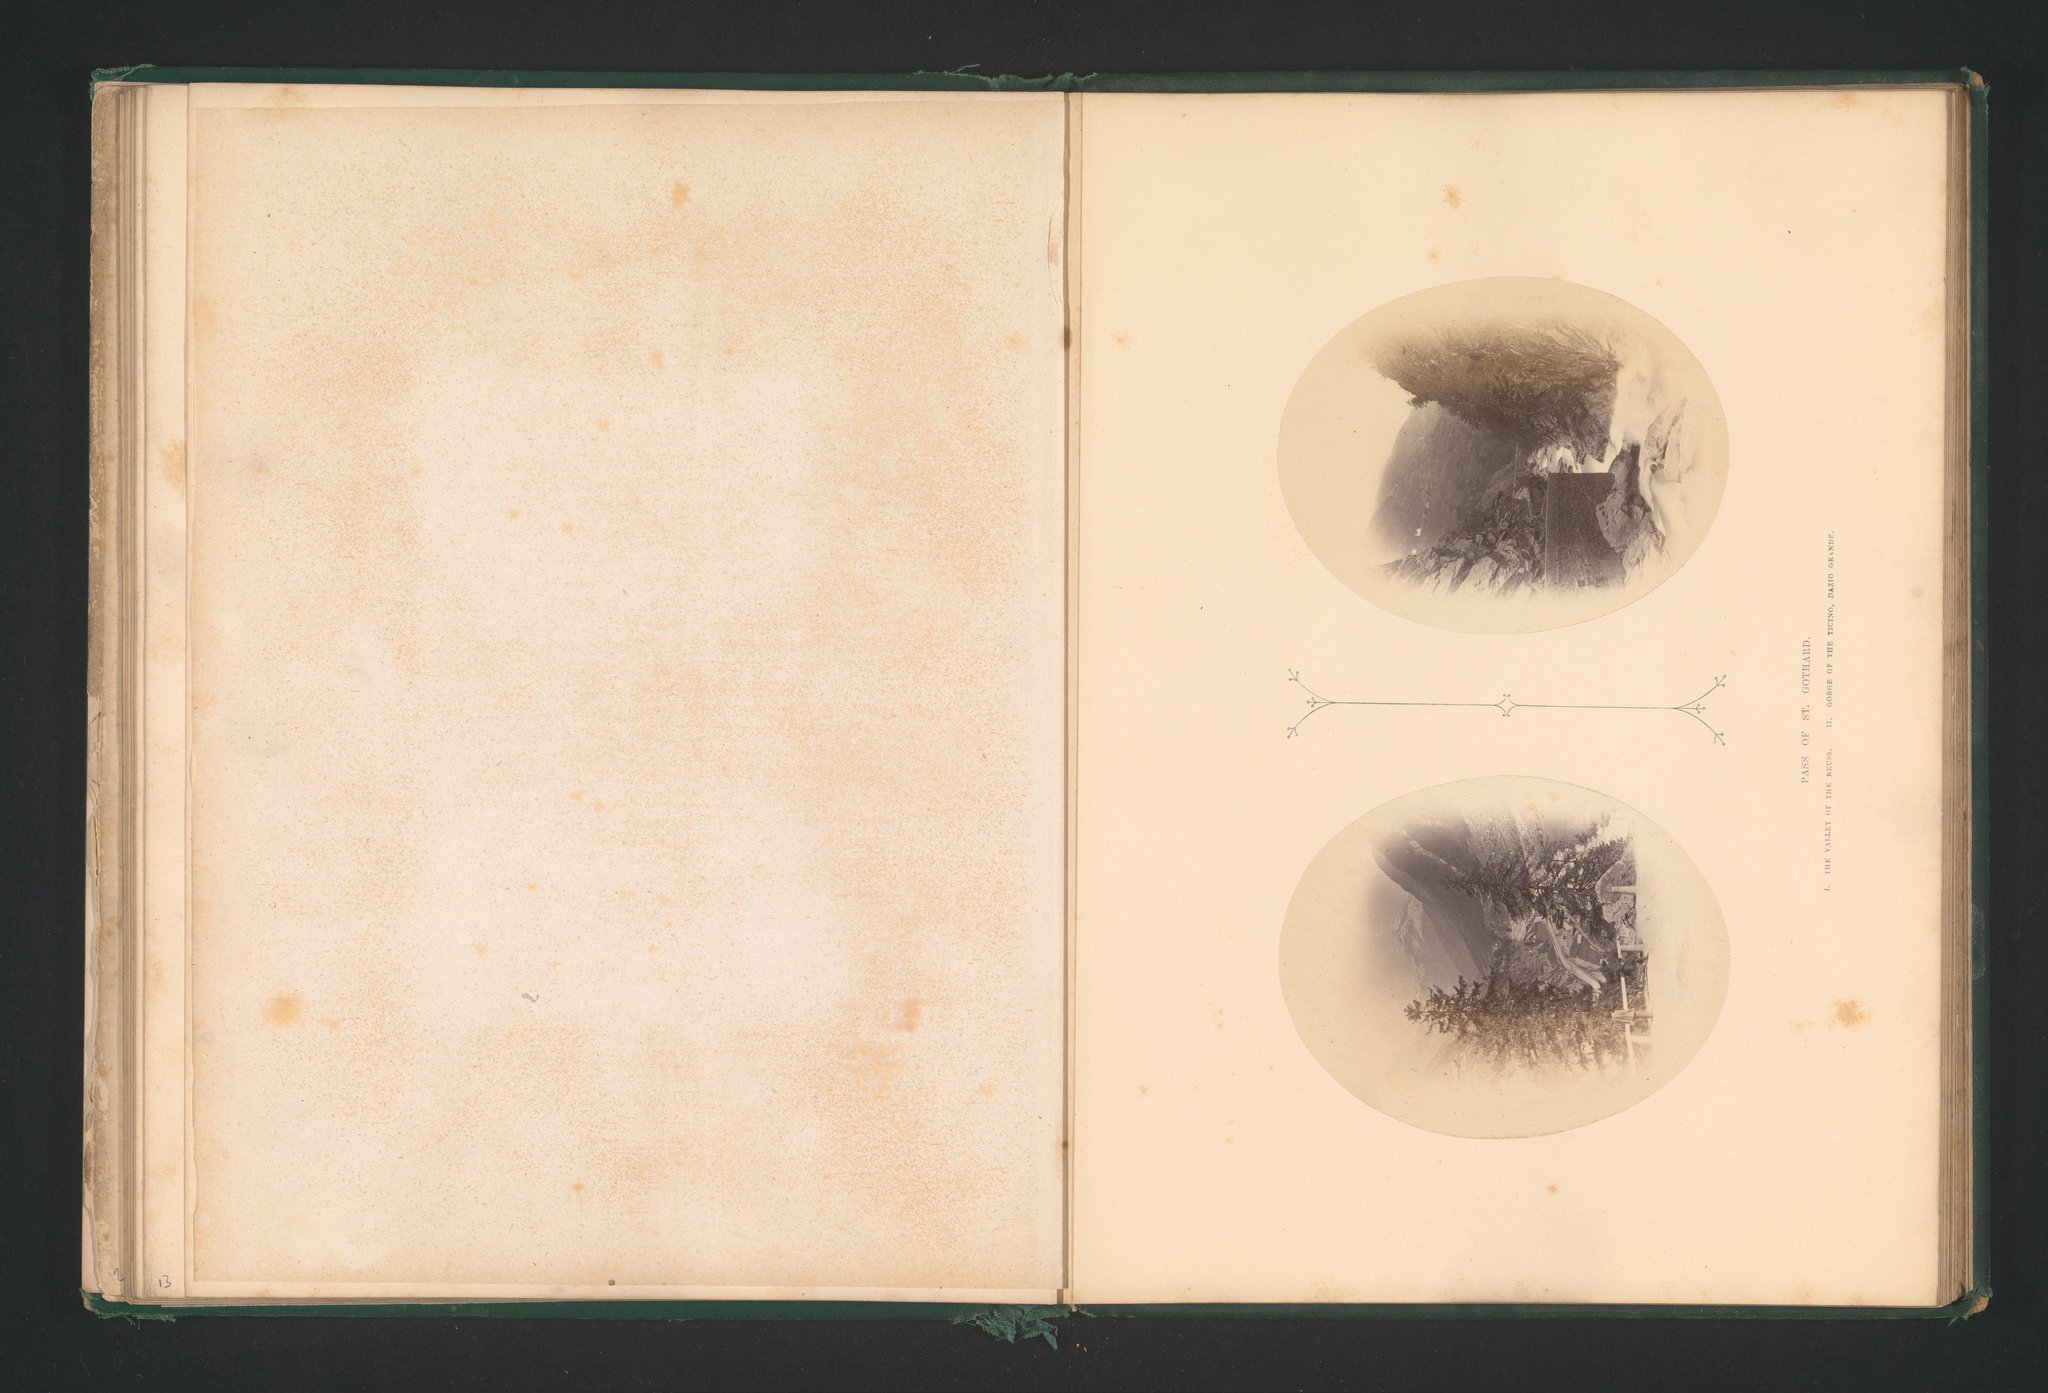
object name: page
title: Gezicht op de Gotthardpas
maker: stephen thompson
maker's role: fotograaf, schrijver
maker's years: 1831-1893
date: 1863-1868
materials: photographic support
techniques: albumen print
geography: gotthard pass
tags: landscapes (+ landscape with figures, staffage), mountains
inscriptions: inscription: ‘I. The valley of the Reuss’